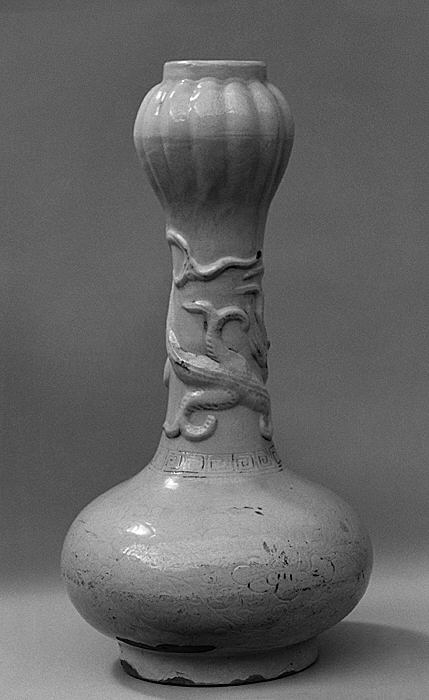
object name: bottle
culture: chinese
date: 1368-1644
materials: clay, glaze